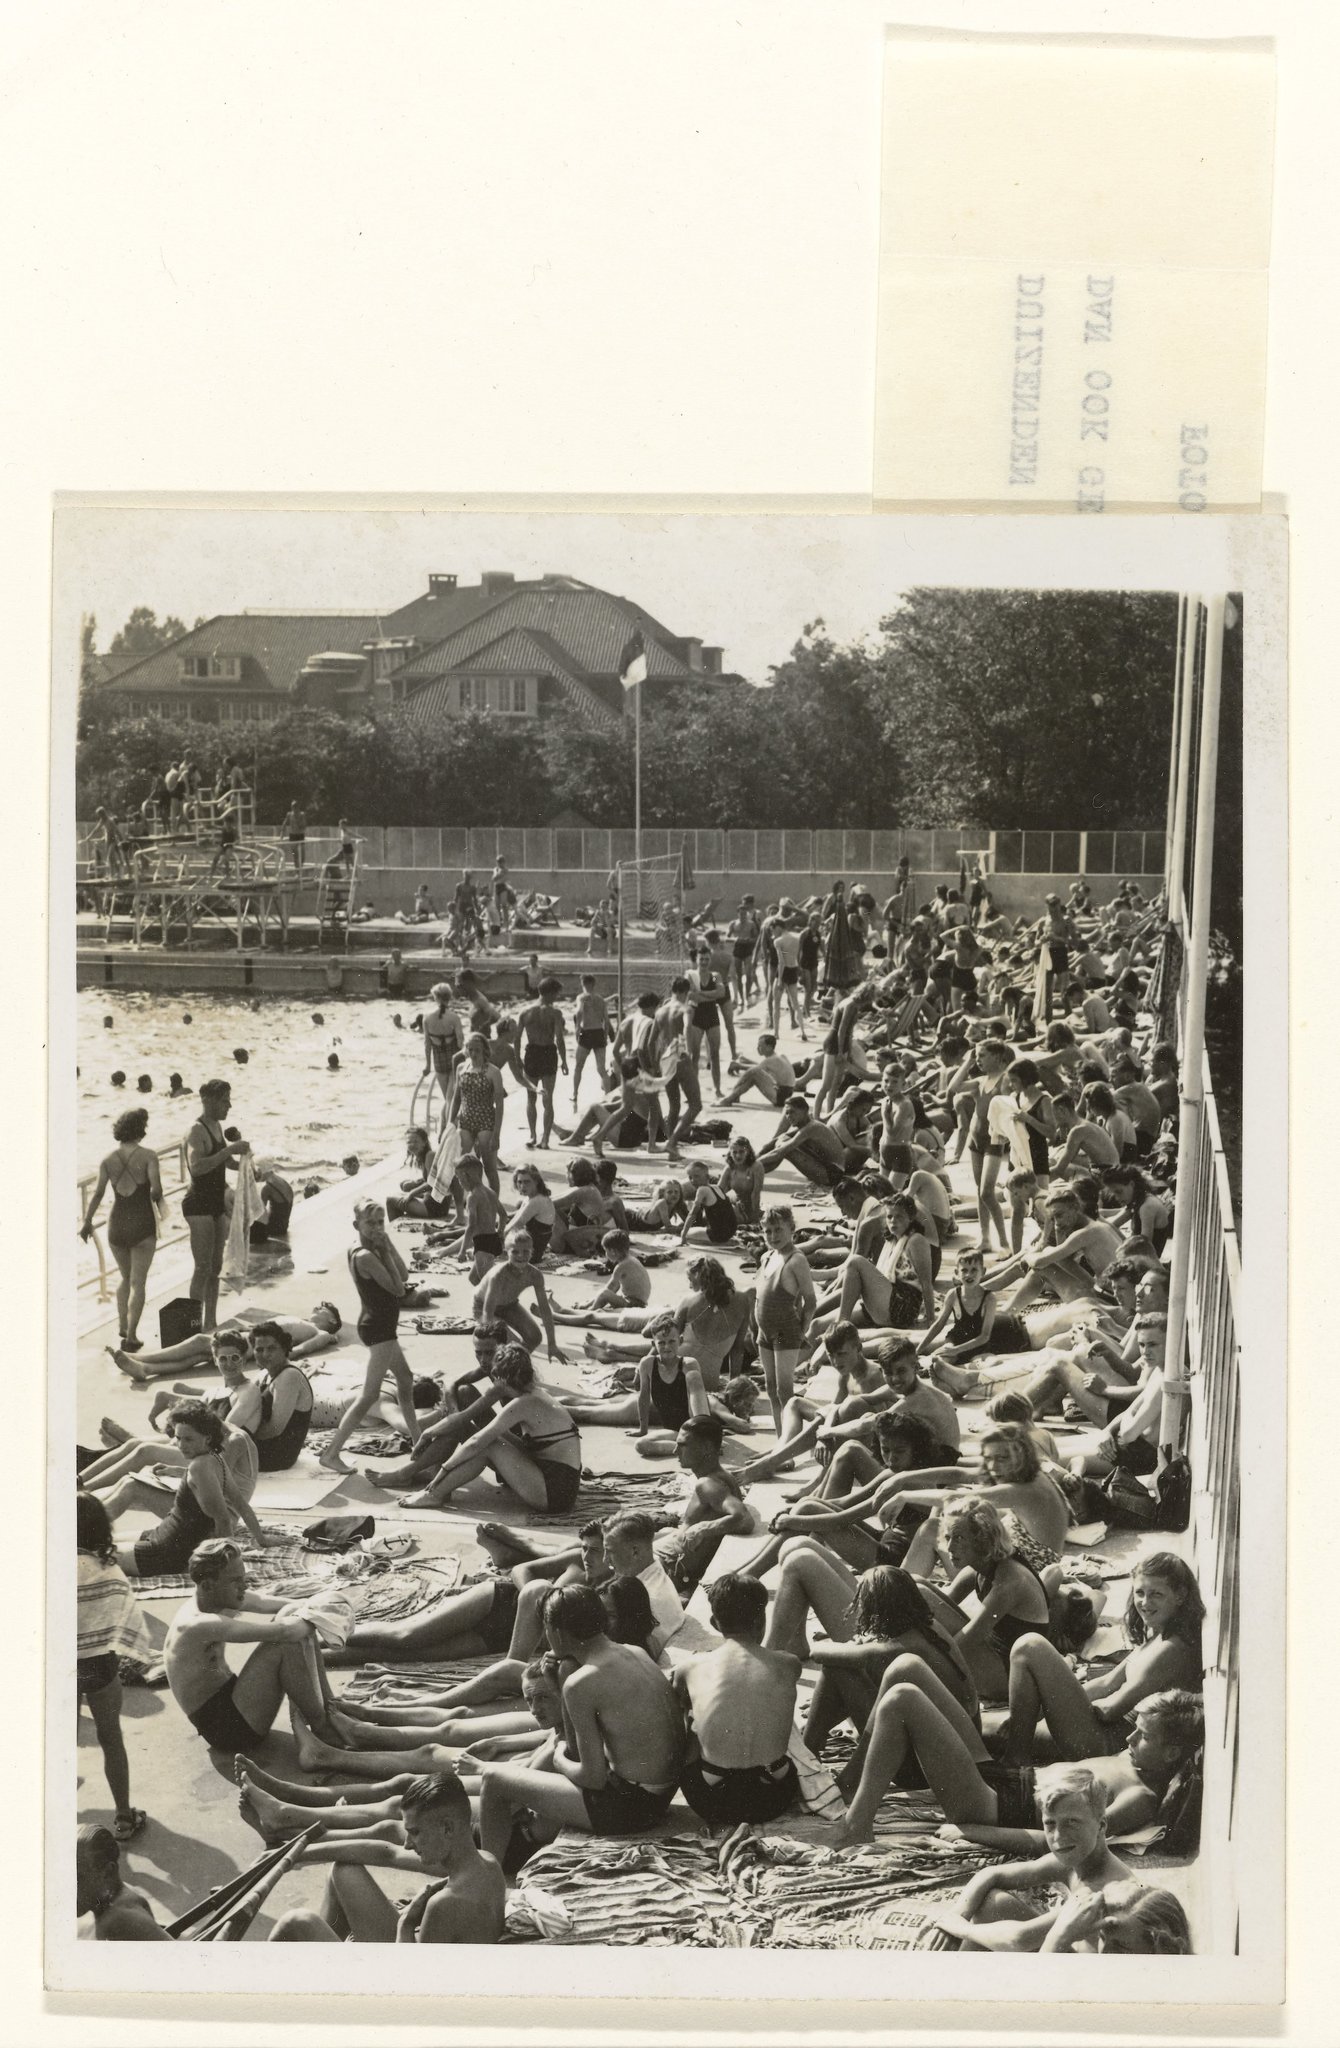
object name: photograph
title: Verfrissing in het zwembad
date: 1942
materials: photographic support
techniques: photography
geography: overveen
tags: overveen, tweede wereldoorlog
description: Een grote groep mensen aan de kant van het zwembad: het Stoop's bad, midden in de oorlog!